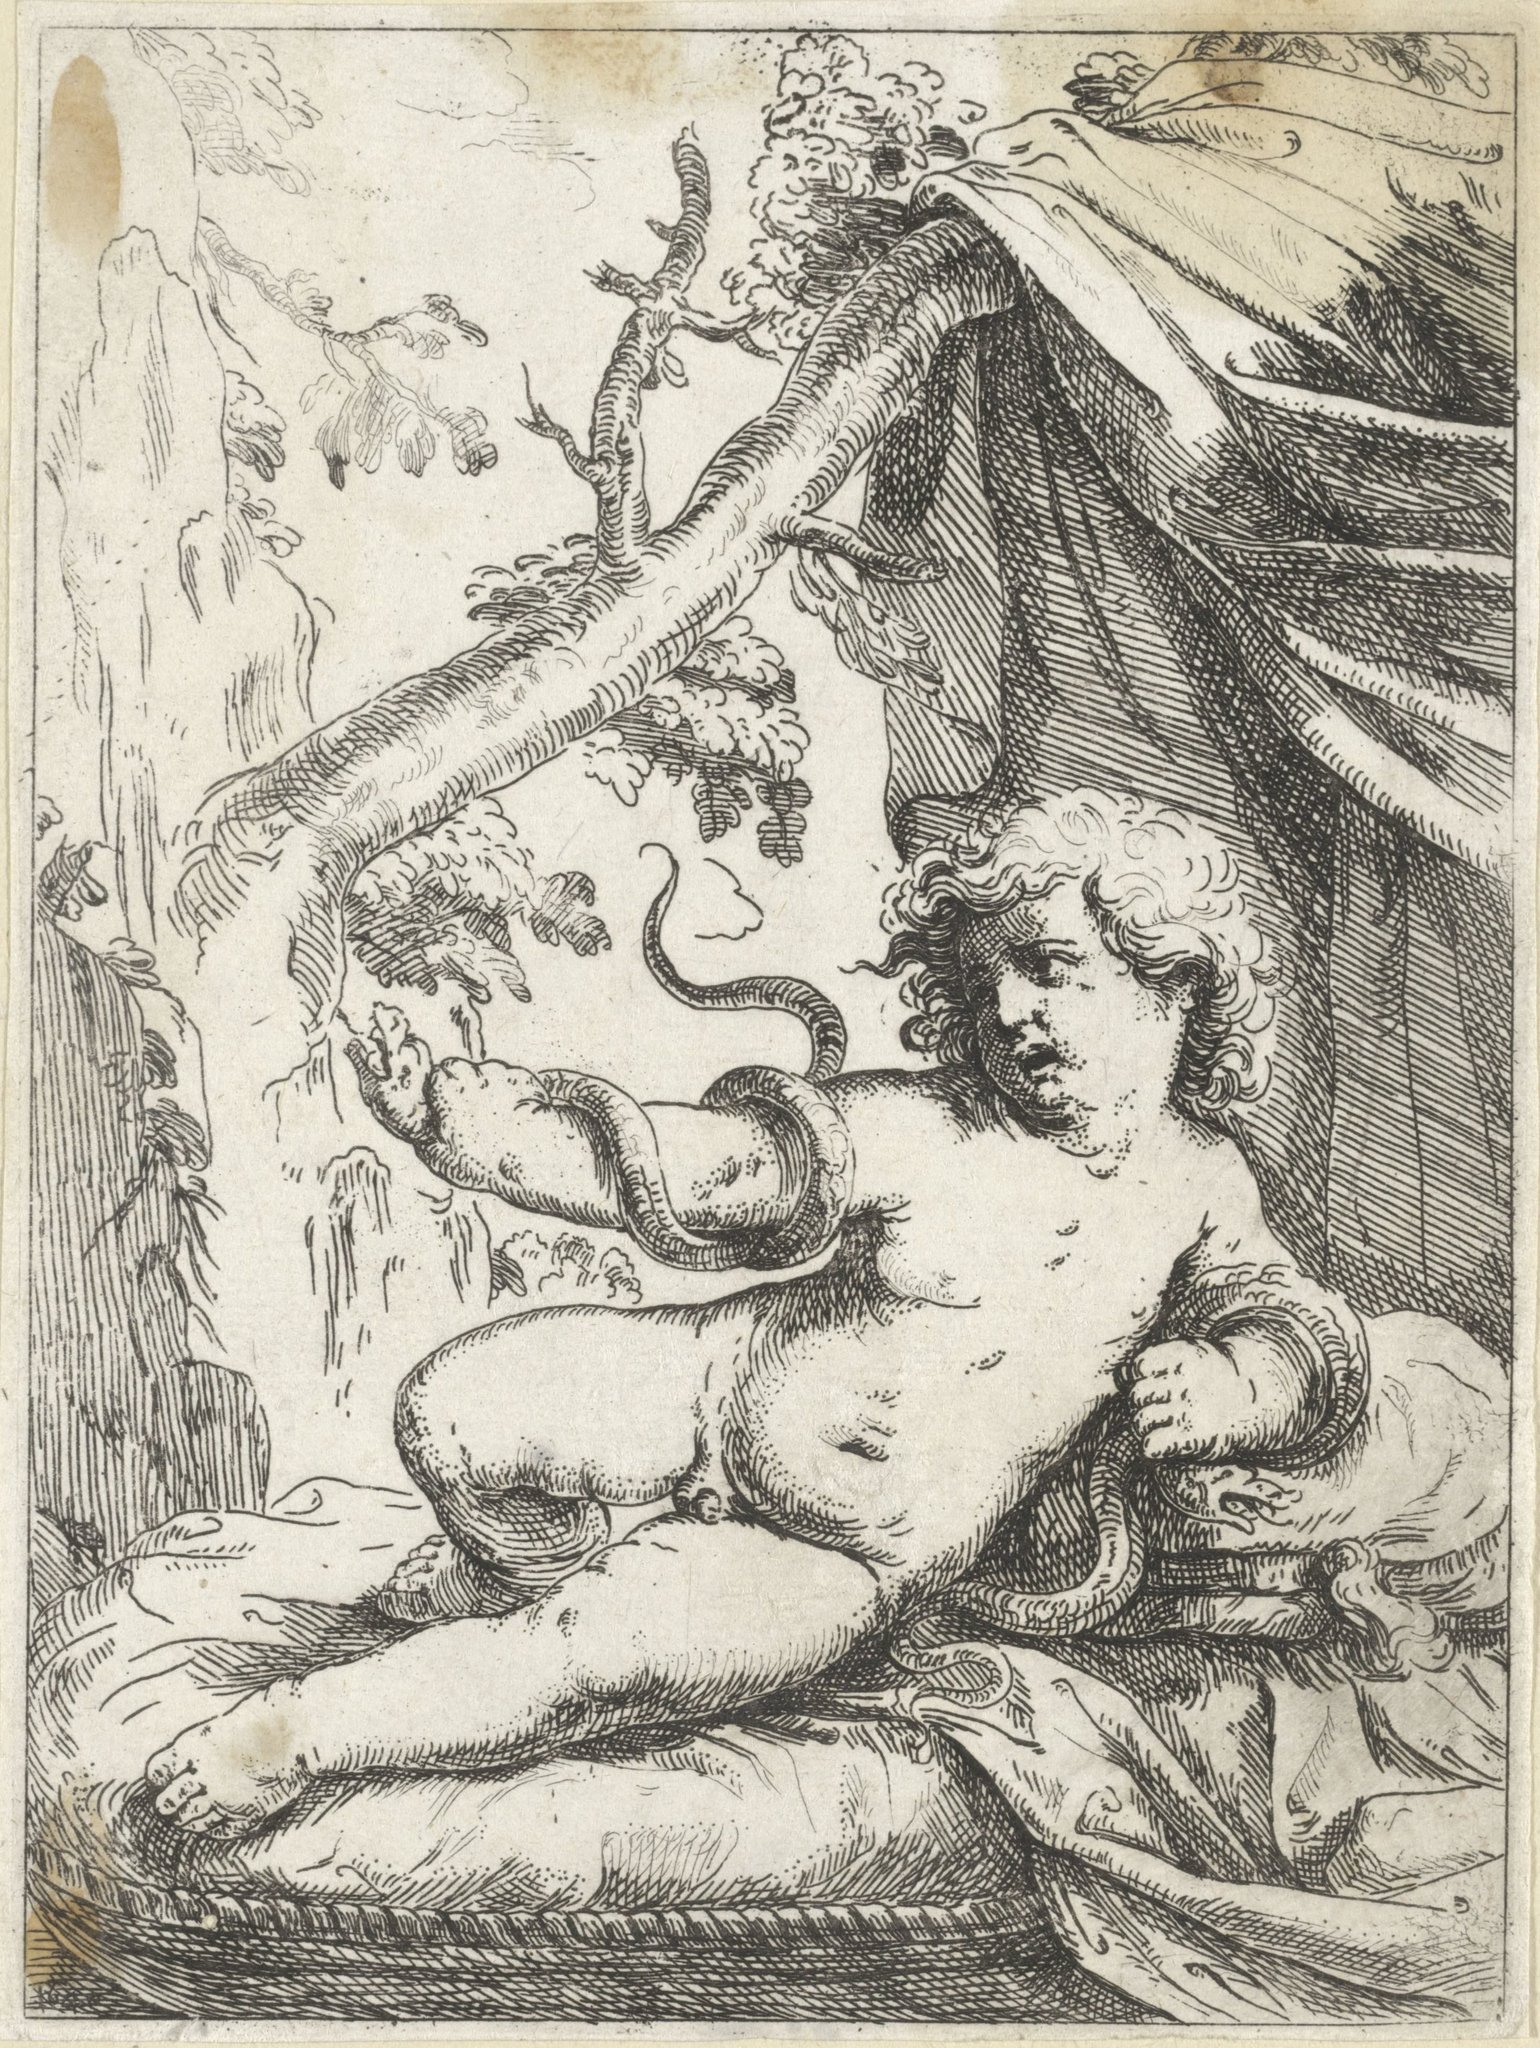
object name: print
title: Hercules in zijn wieg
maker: lorenzo loli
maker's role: print maker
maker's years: 1612-1691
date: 1622-1691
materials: paper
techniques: etching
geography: italy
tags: hercules strangles two serpents in his cradle, cradle, crib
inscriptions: collector's mark: Lugt 240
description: De jonge Hercules ligt in zijn wieg en wurgt in beide handen een slang. Een tentdoek is gespannen over een boomtak.